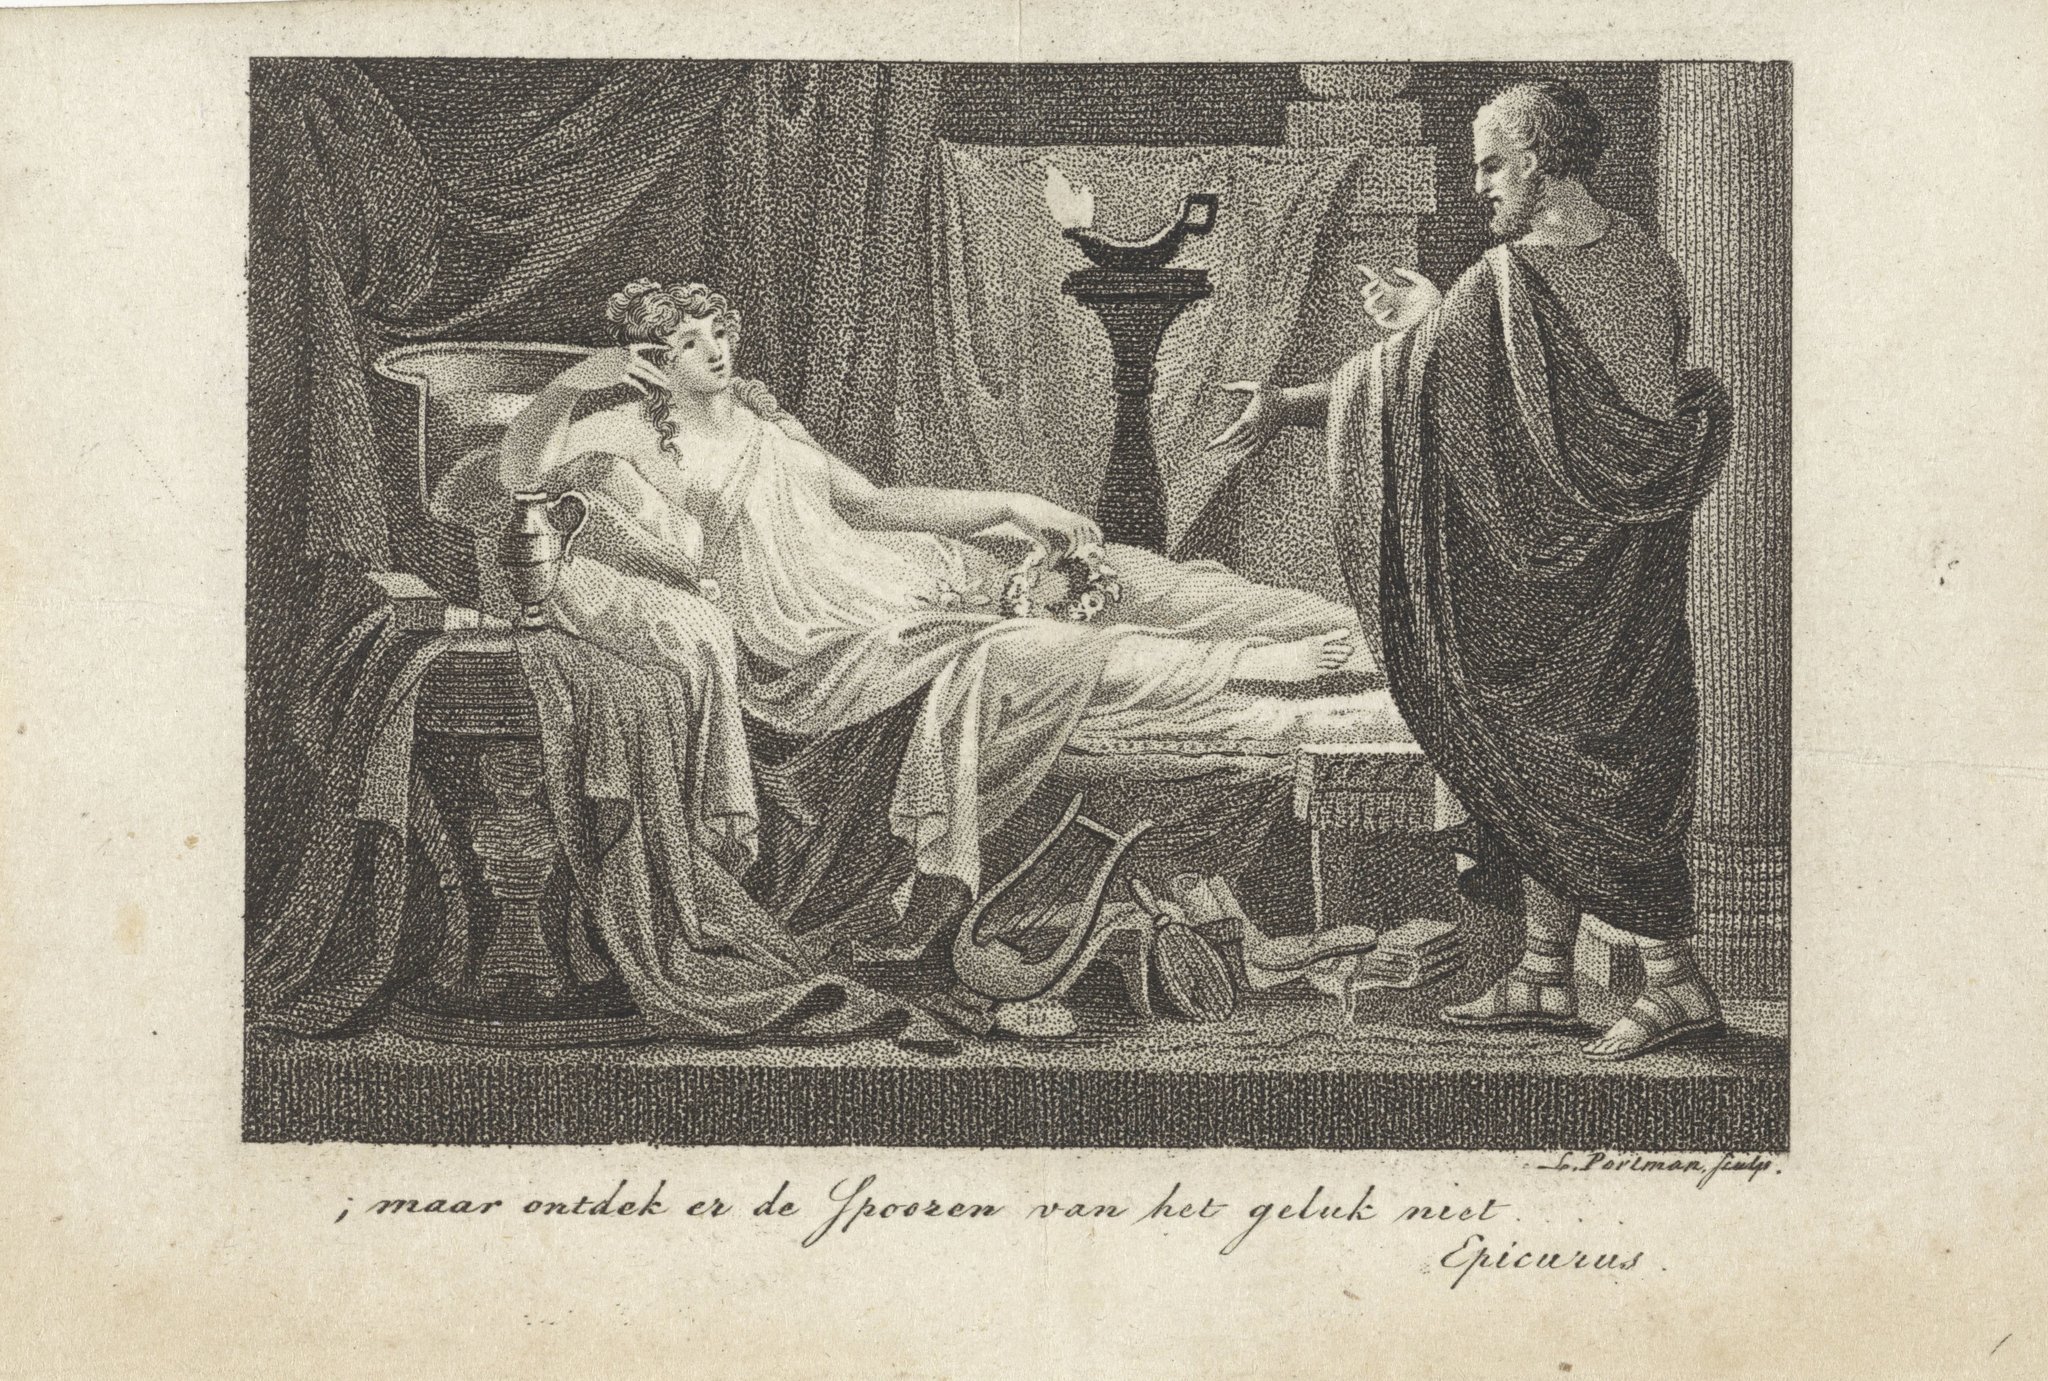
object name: print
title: ; maar ontdek er de Spooren van het geluk niet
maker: ludwig gottlieb portman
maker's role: print maker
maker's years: 1772-1828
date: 1803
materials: paper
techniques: etching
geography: amsterdam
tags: epicurus, the philosopher - love-affairs of person from classical history, specific works of literature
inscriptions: collector's mark: Lugt 2228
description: De courtisane Leontium op een ligbank in een vertrek. Ze luistert naar Epicurus, die bij het voeteneinde staat. Illustratie van een scène uit 'Epicurus bij Leontium'.